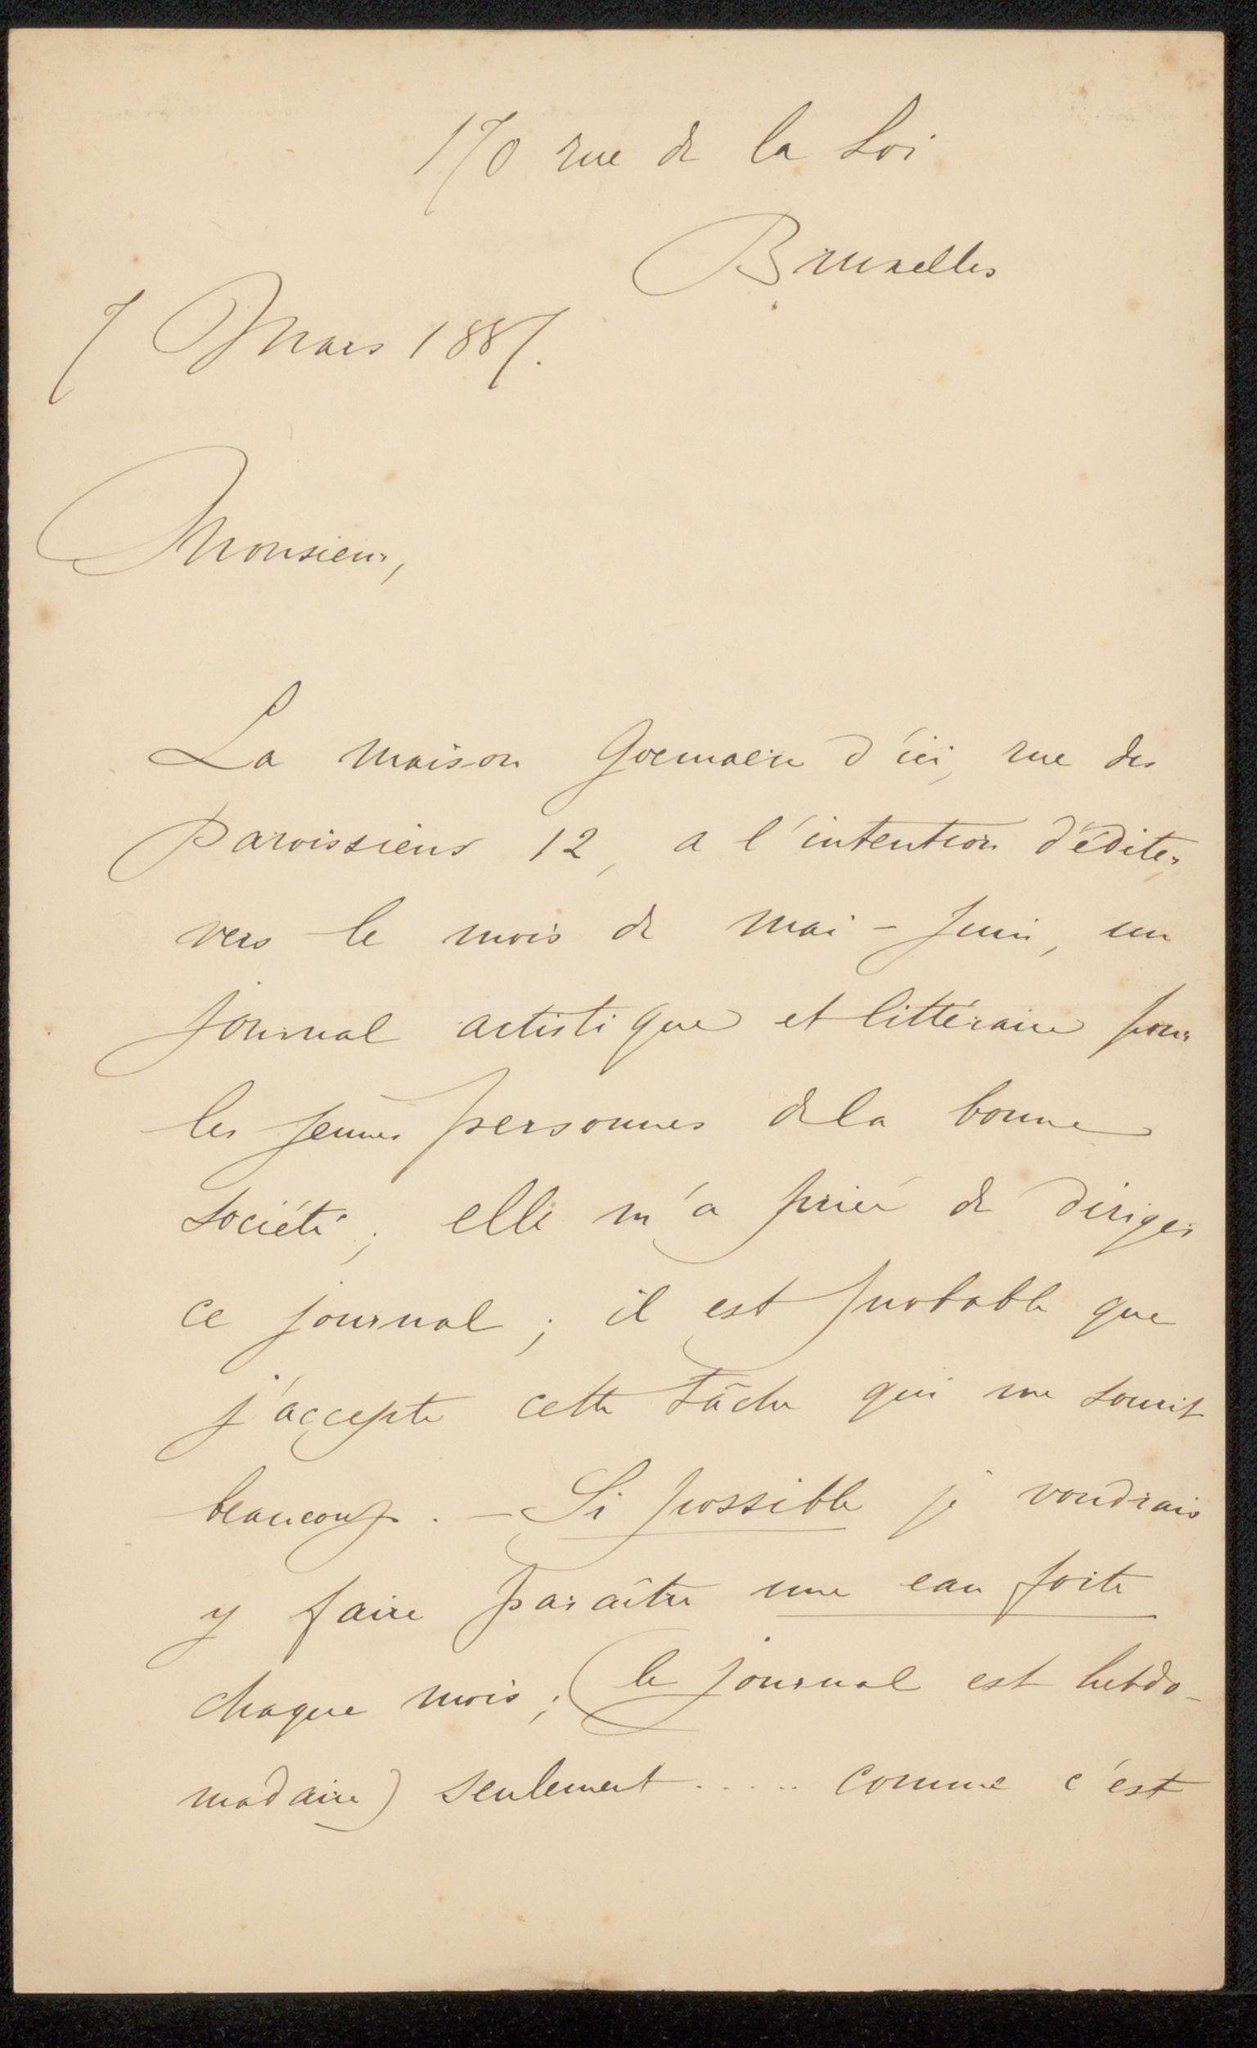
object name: letter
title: Brief aan Philip Zilcken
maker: catharina alberdingk thijm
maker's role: schrijver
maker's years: 1848-1908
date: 1887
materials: ink, paper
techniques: pen, writing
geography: brussels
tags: the hague, painter, draughtsman, philip zilcken, printed matter, brussels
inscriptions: collector's mark: ‘RPK’